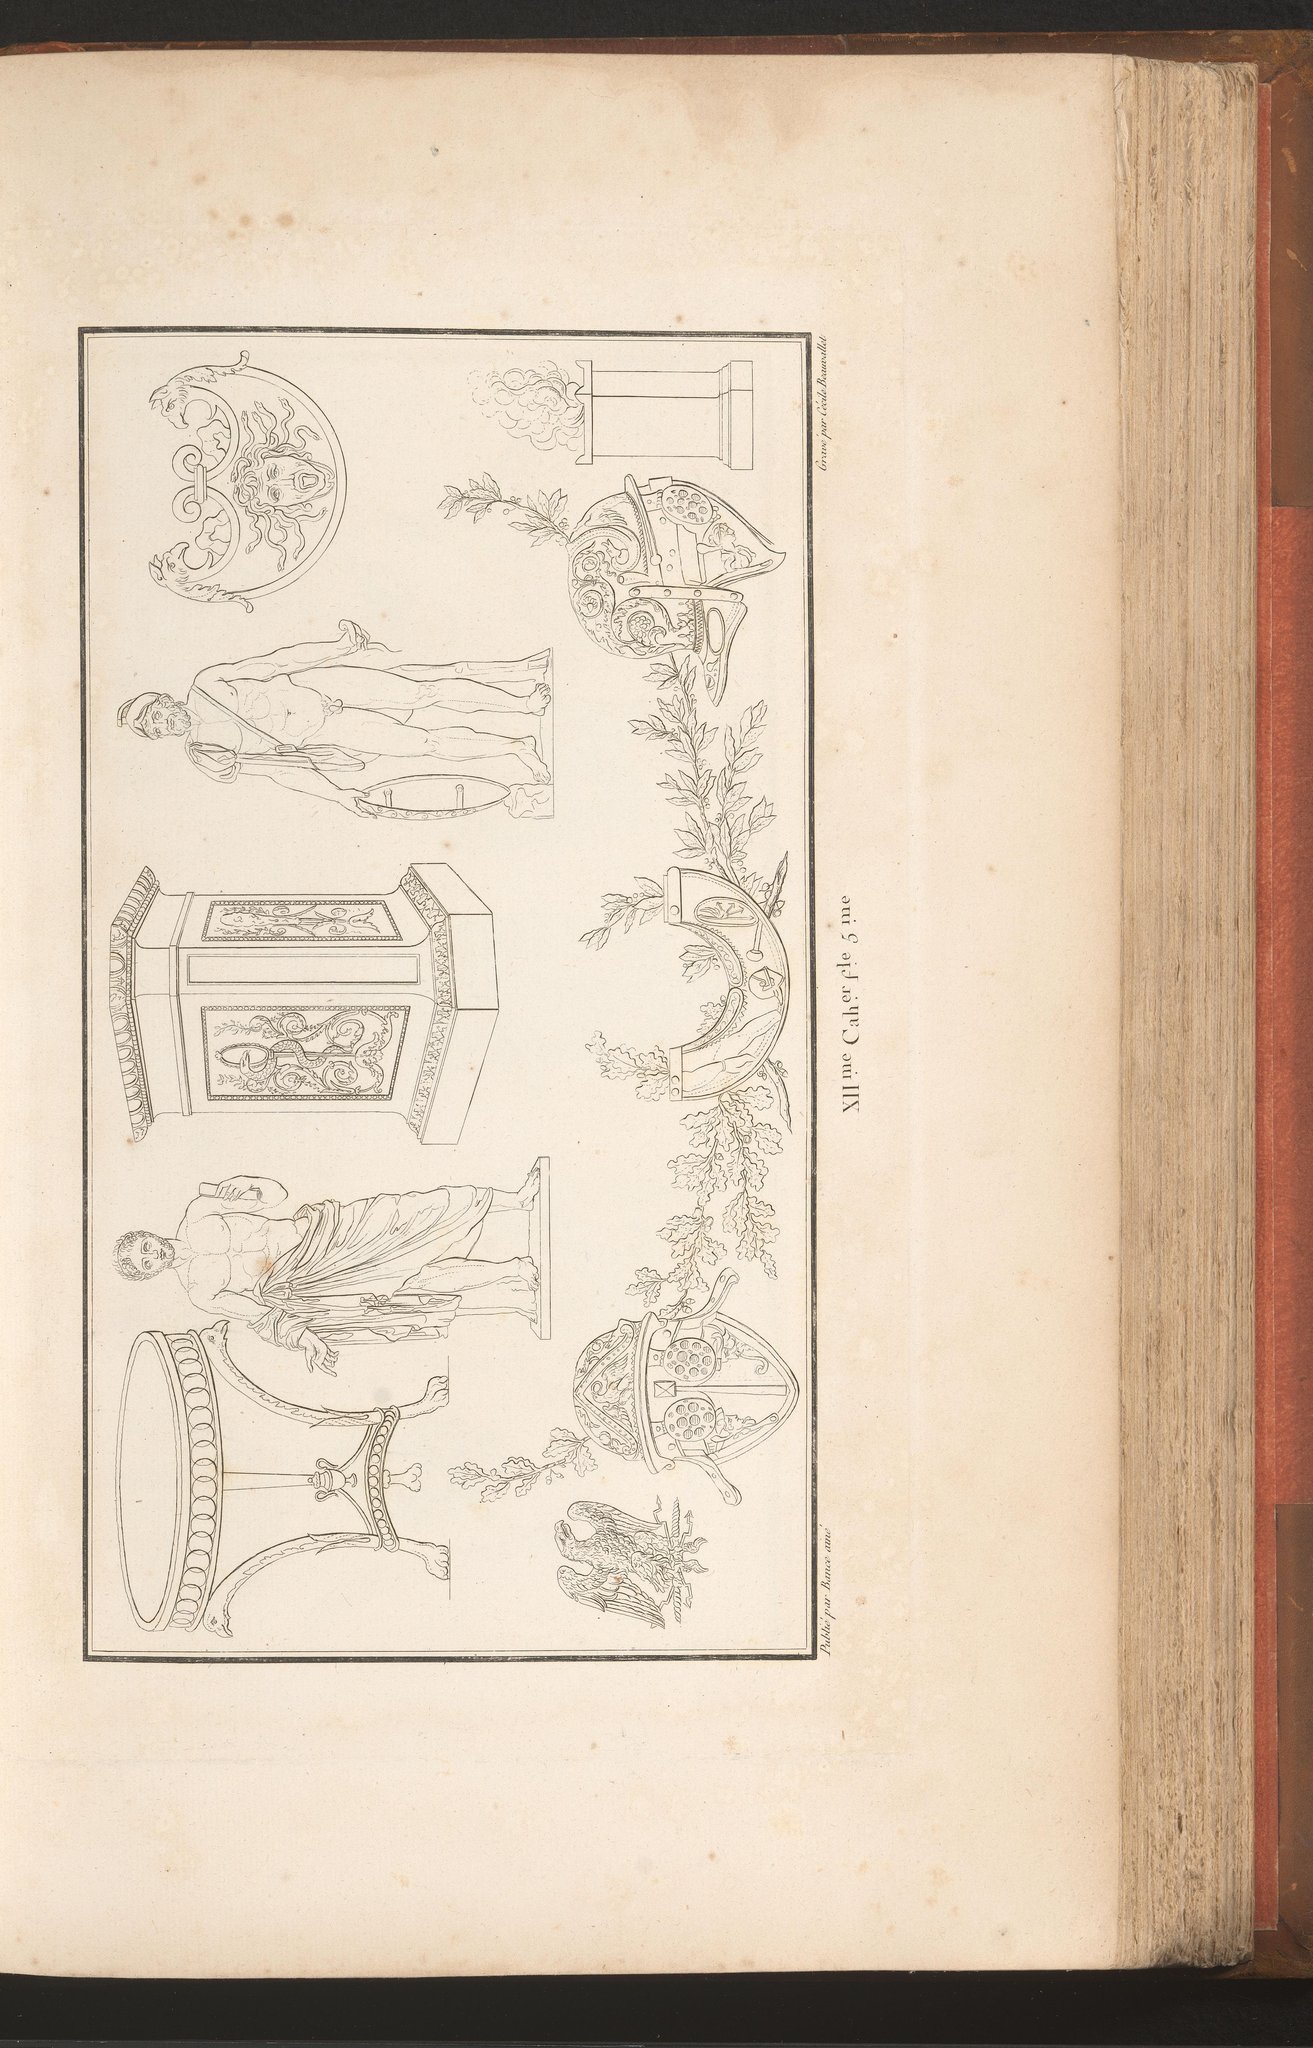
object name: ornament print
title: Diverse ornamenten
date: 1820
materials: paper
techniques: etching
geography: paris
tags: standing figure, ornaments ~ art, piece of sculpture, reproduction of a piece of sculpture, altar ~ roman religion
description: Ornamentprent met centraal twee staande mannelijke figuren aan weerszijden van een altaar. Onderdeel (XIIe. Cah. f.le 5) van het prentalbum met twee series van in totaal 138 ornamentprenten door Beauvallet en Normand, 'Fragmens d'Ornemens dans le Style Antique'.